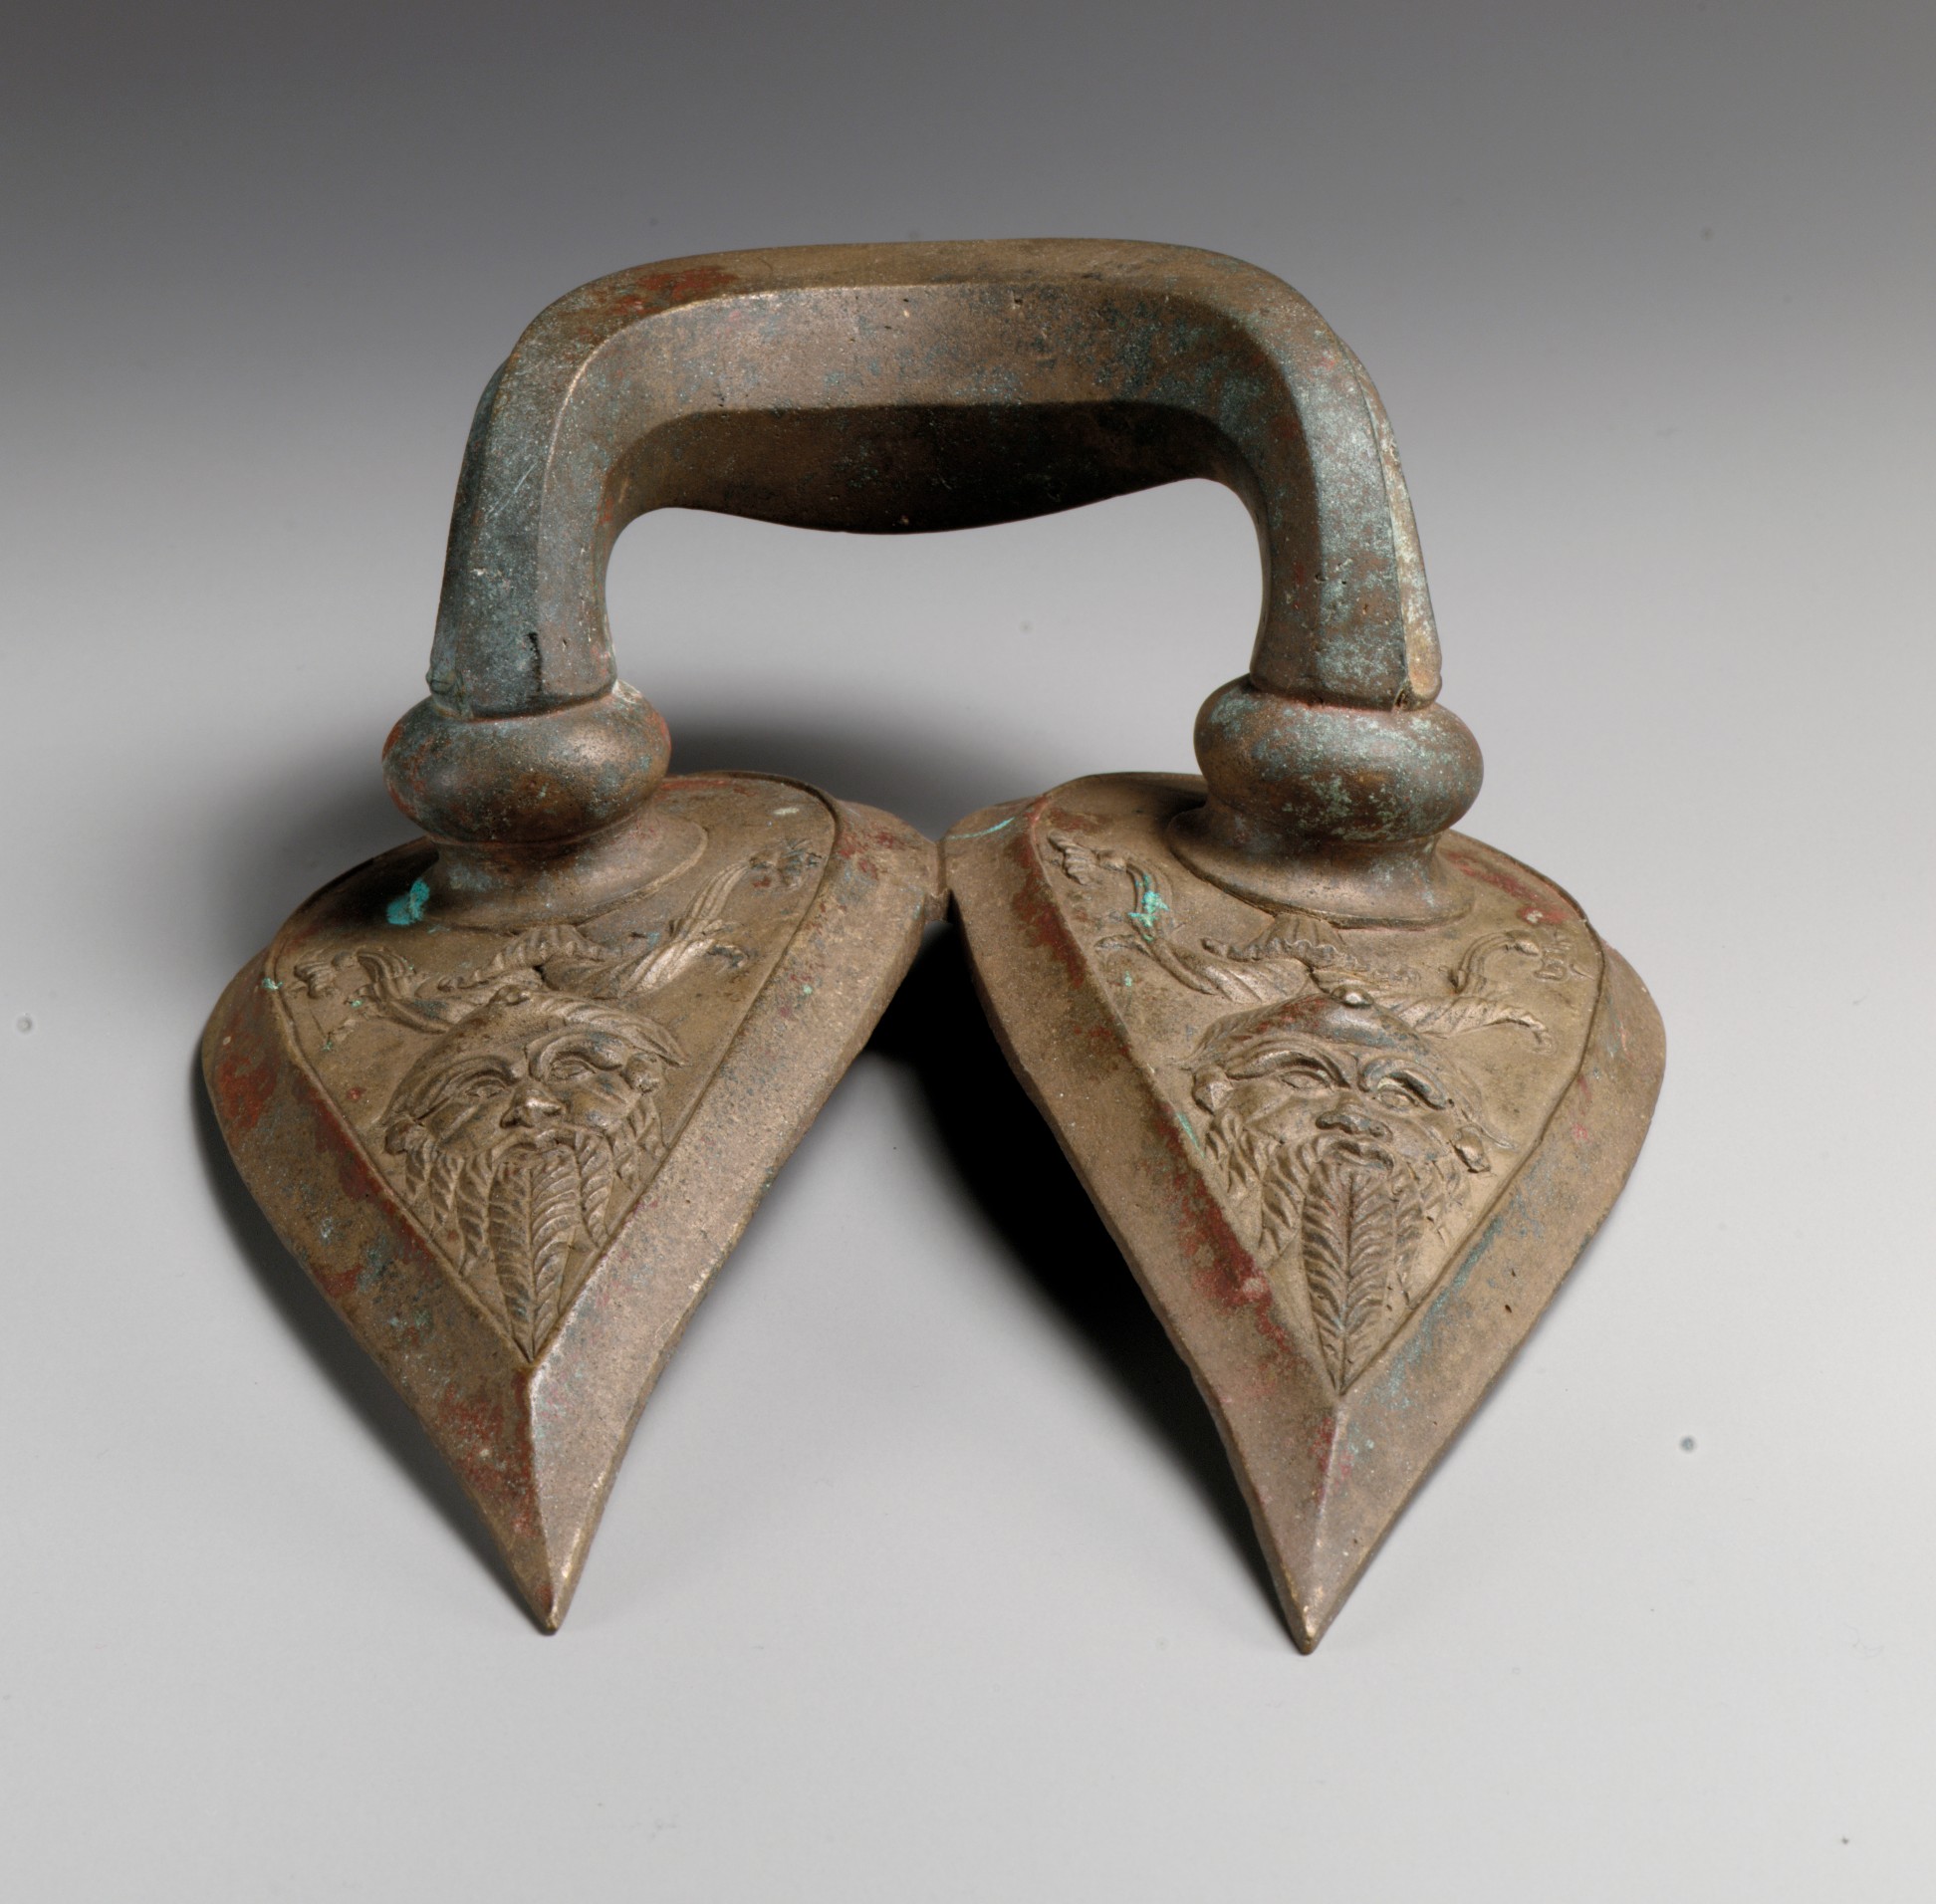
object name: handle with silenos mask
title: Bronze handle of a vessel with Silenos mask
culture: etruscan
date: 400-368 BCE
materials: bronze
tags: masks